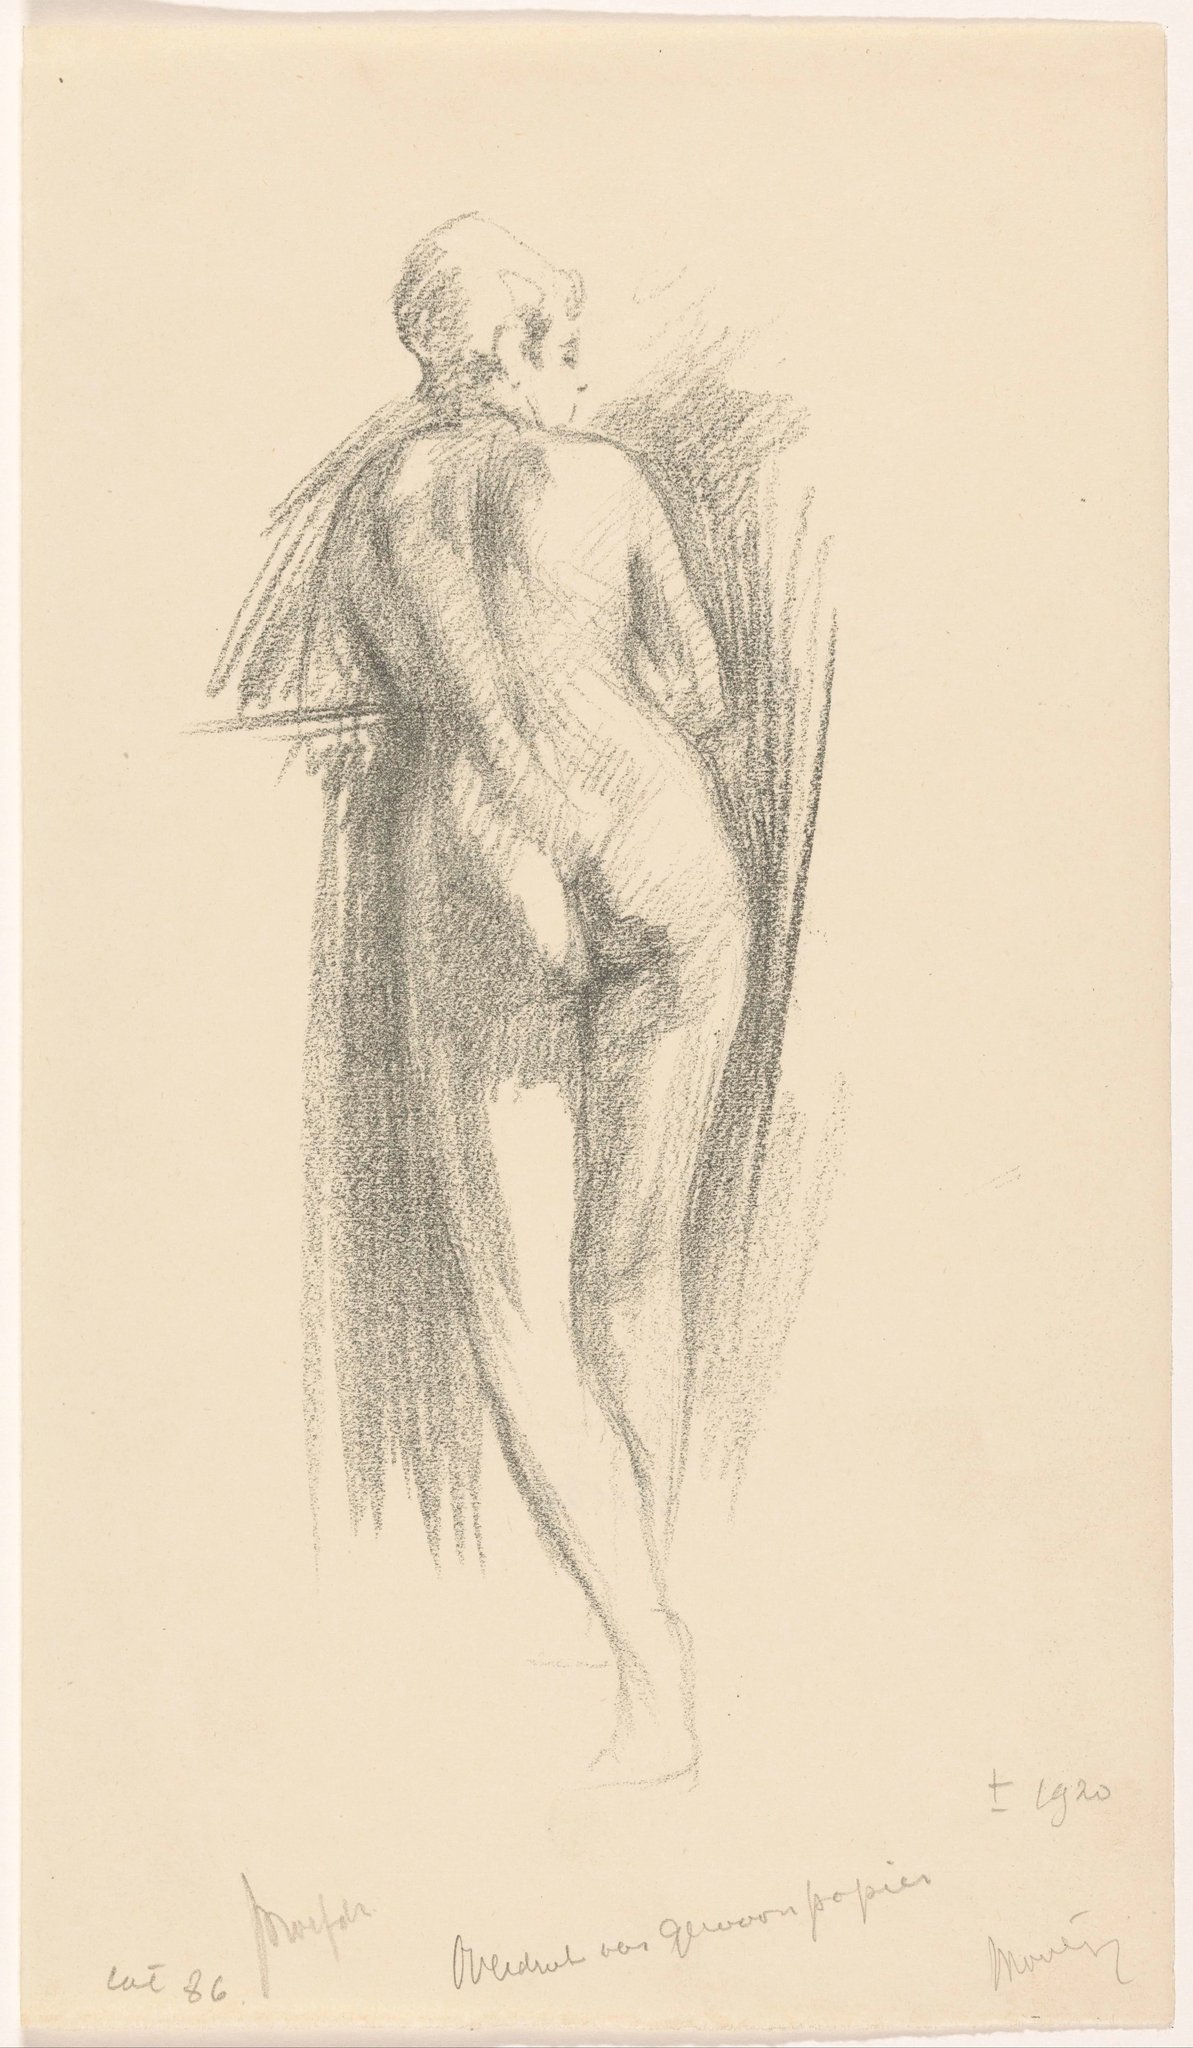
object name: print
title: Staande naakte vrouw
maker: simon moulijn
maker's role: draughtsman, print maker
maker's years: 1866-1948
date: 1920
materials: paper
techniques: lithograph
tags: woman (showing herself) undressed, quasi-nude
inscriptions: collector's mark: Lugt 2228, annotation: ‘Overdruk van gewoon papier’